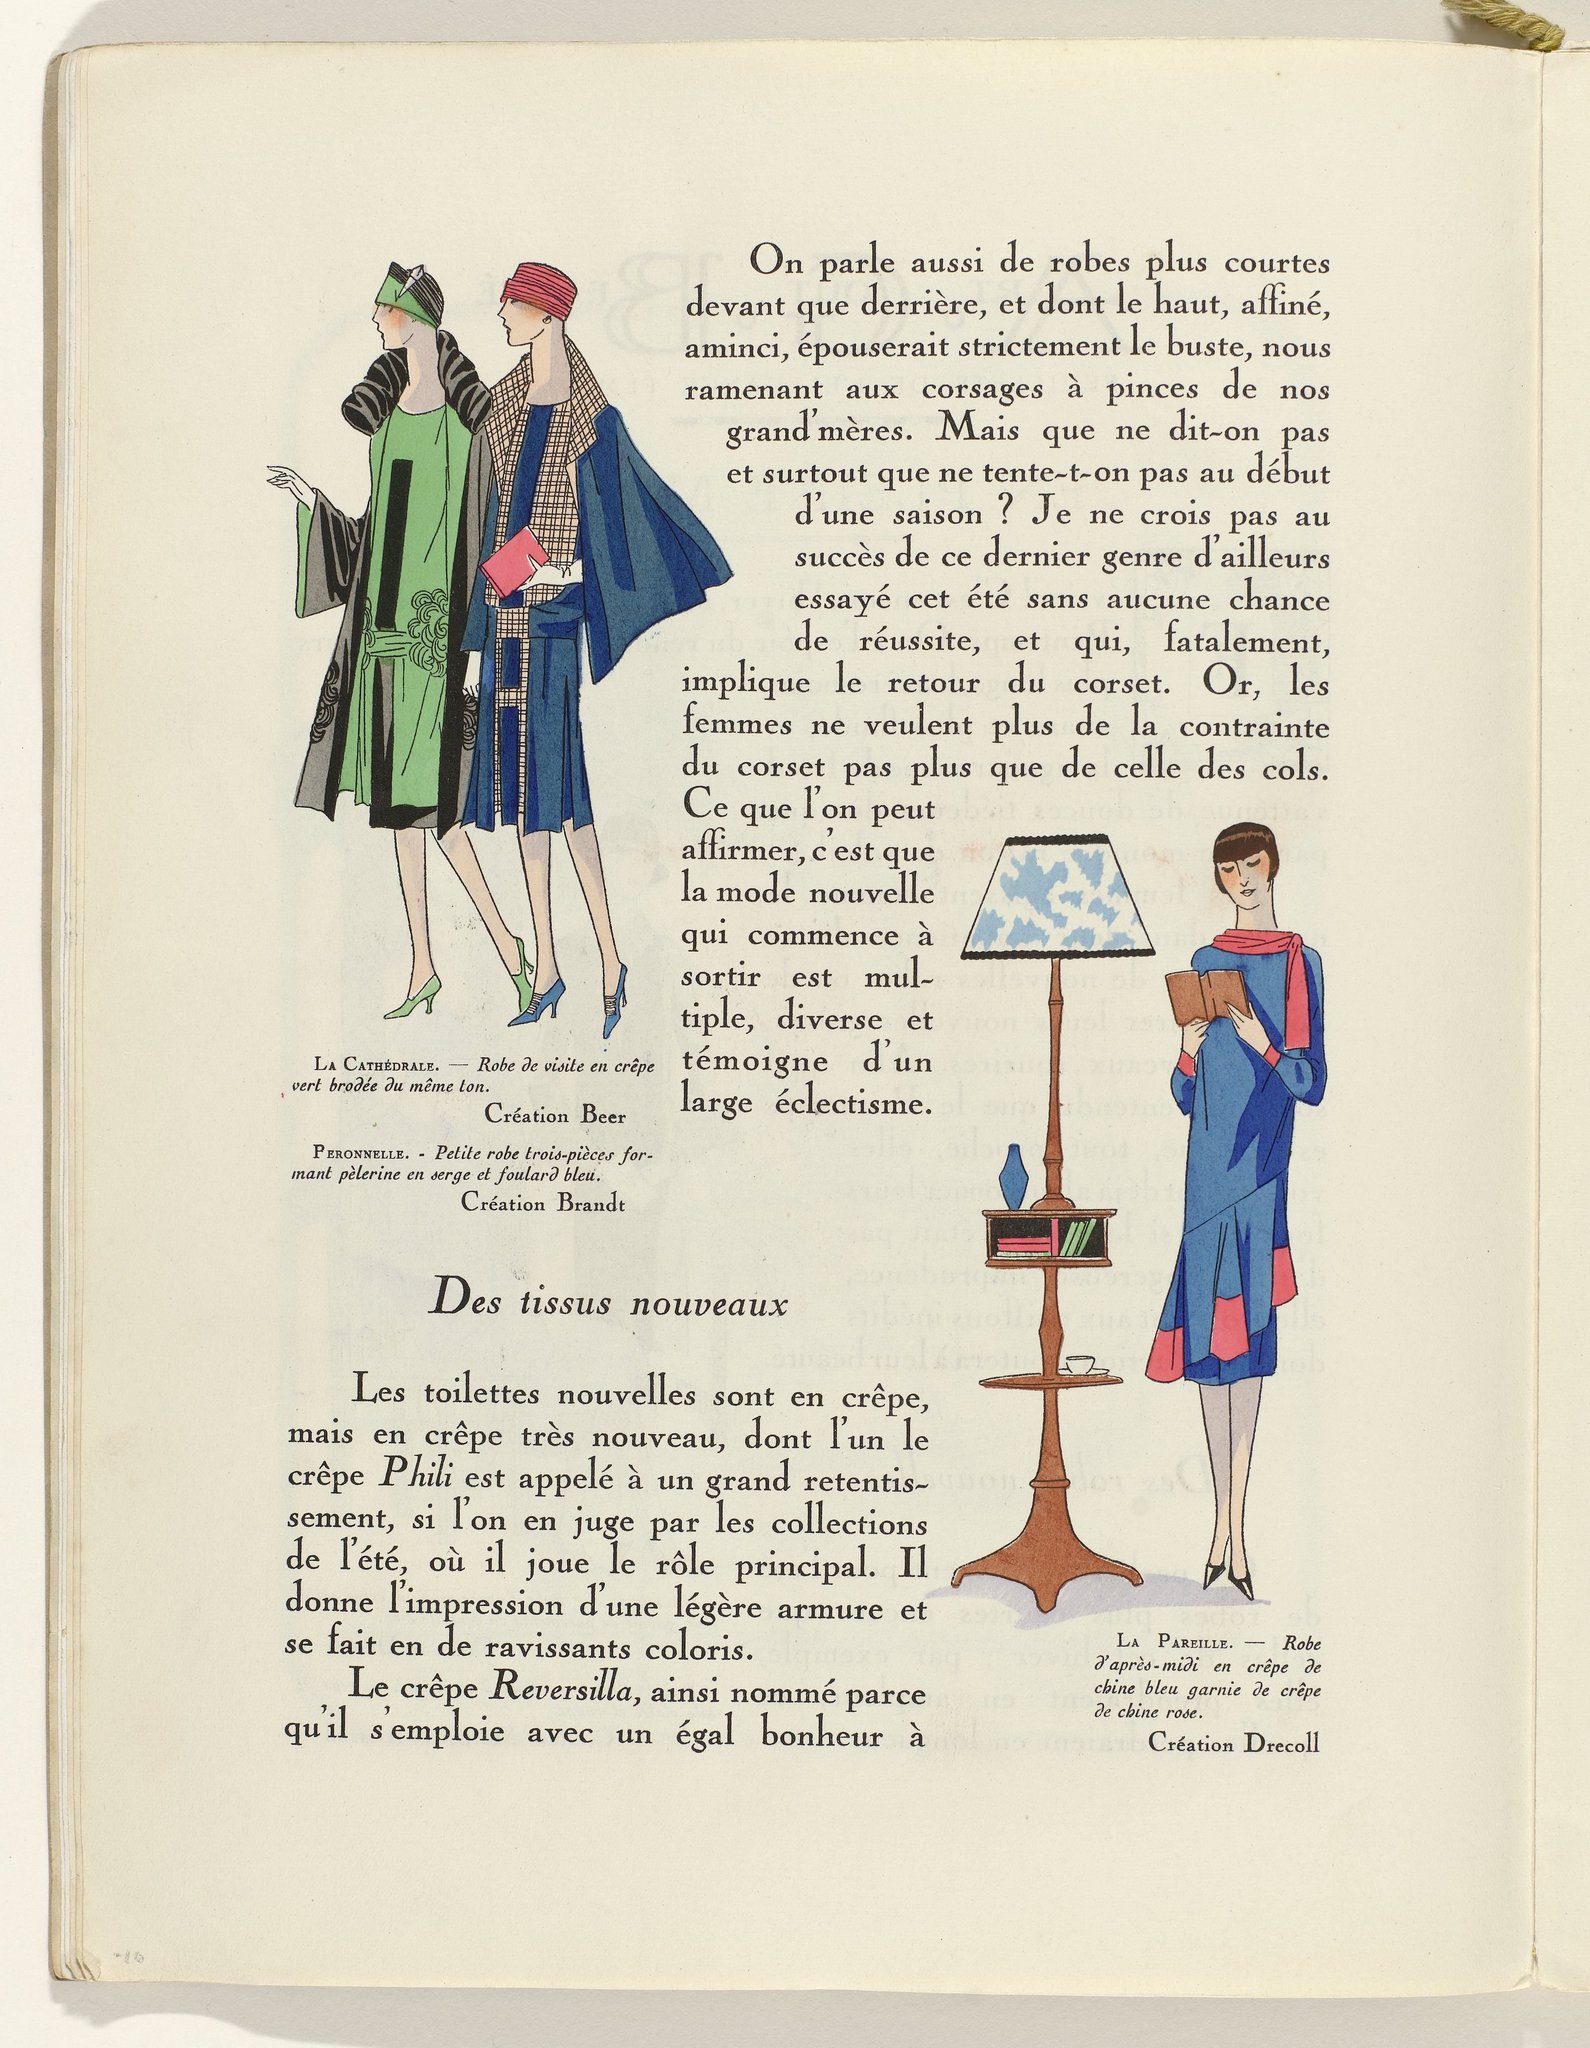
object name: magazine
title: Art - Goût - Beauté, Feuillets de l' élégance féminine, Février 1926, No. 66, 6e Année, p. 10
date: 1926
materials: paper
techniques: hand coloring, lithograph, pochoir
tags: reading, dress, gown: day dress (+ women's clothes), ensembles of pieces of clothing (three piece suit) (+ women's clothes), dress, gown (visiting dress) (+ women's clothes), dress, gown (afternoon dress) (+ women's clothes), clothing for the upper part of the body (mantelet) (+ women's clothes), fashion plates, head-gear: hat (+ women's clothes)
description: Linksboven: een visitejapon van geborduurde groene crêpe, van Beer. 'Robe trois-pièces formant pelerine' van serge en blauwe foulard, van Brandt. Rechtsonder: middagjapon van blauwe crêpe de chine gegarneerd met roze crêpe de chine, van Drecoll. Pagina uit het modetijdschrift Art-Goût-Beauté (1920-1933).